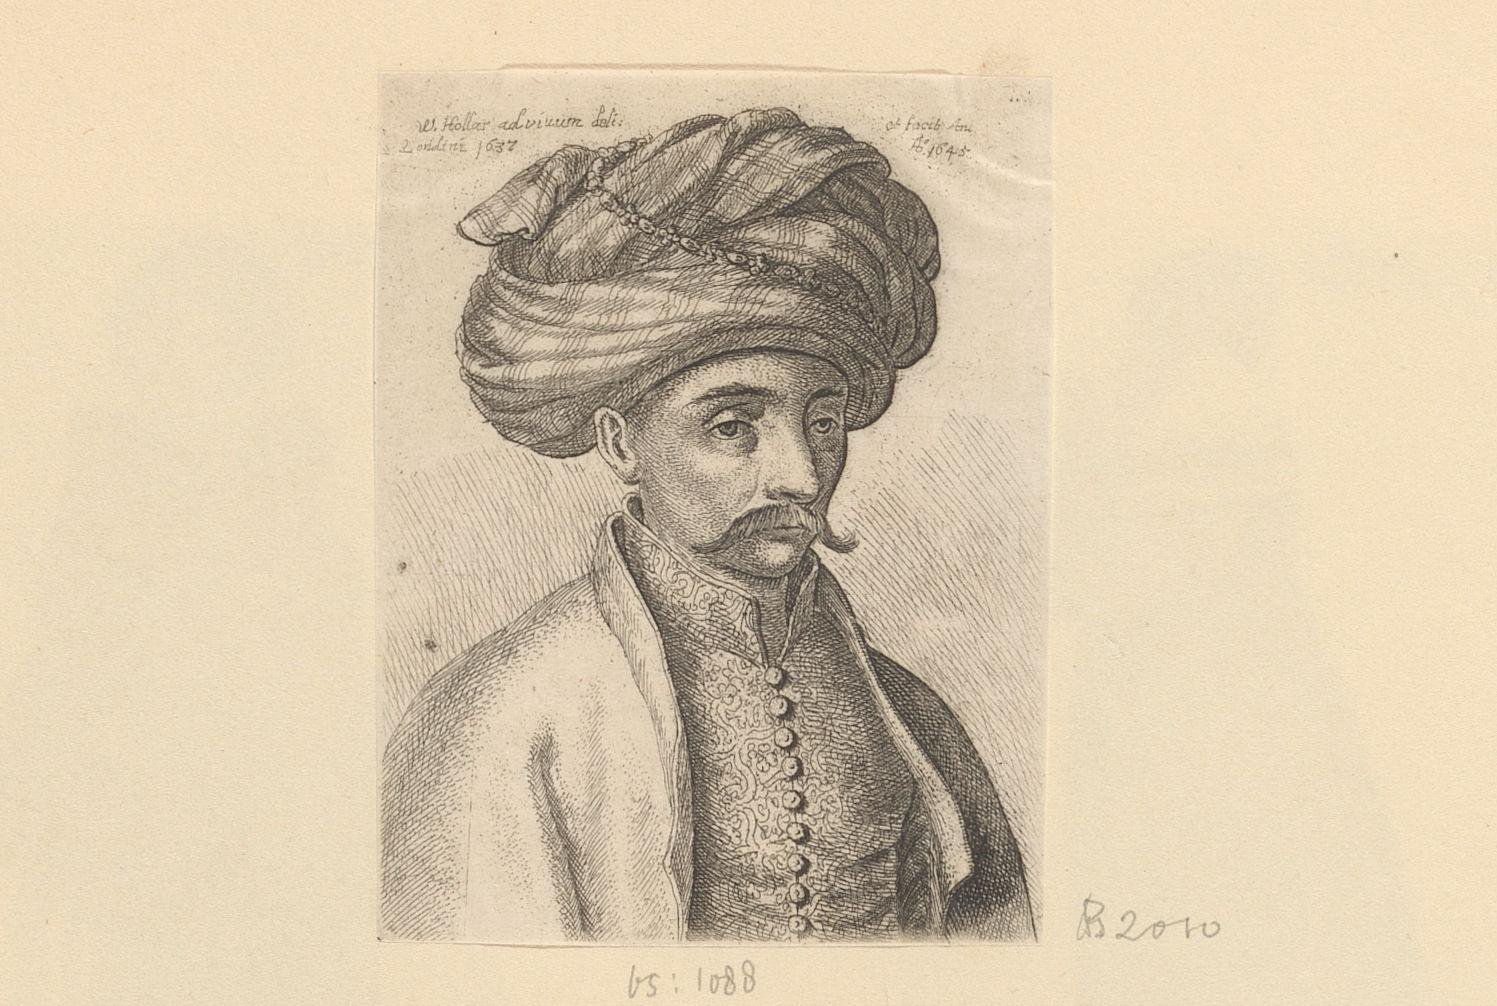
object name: print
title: Portret van een onbekende man met snor en tulband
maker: wenceslaus hollar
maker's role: draughtsman, print maker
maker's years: 1607-1677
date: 1637-1645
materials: paper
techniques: etching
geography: london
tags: historical persons, head-gear: turban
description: Prent maakt mogelijk deel uit van een serie van 200 prenten. Deze serie is onder de titel 'A Collection of two hundred original etchings' voor het eerst uitgegeven door J.M. Greery in 1816.